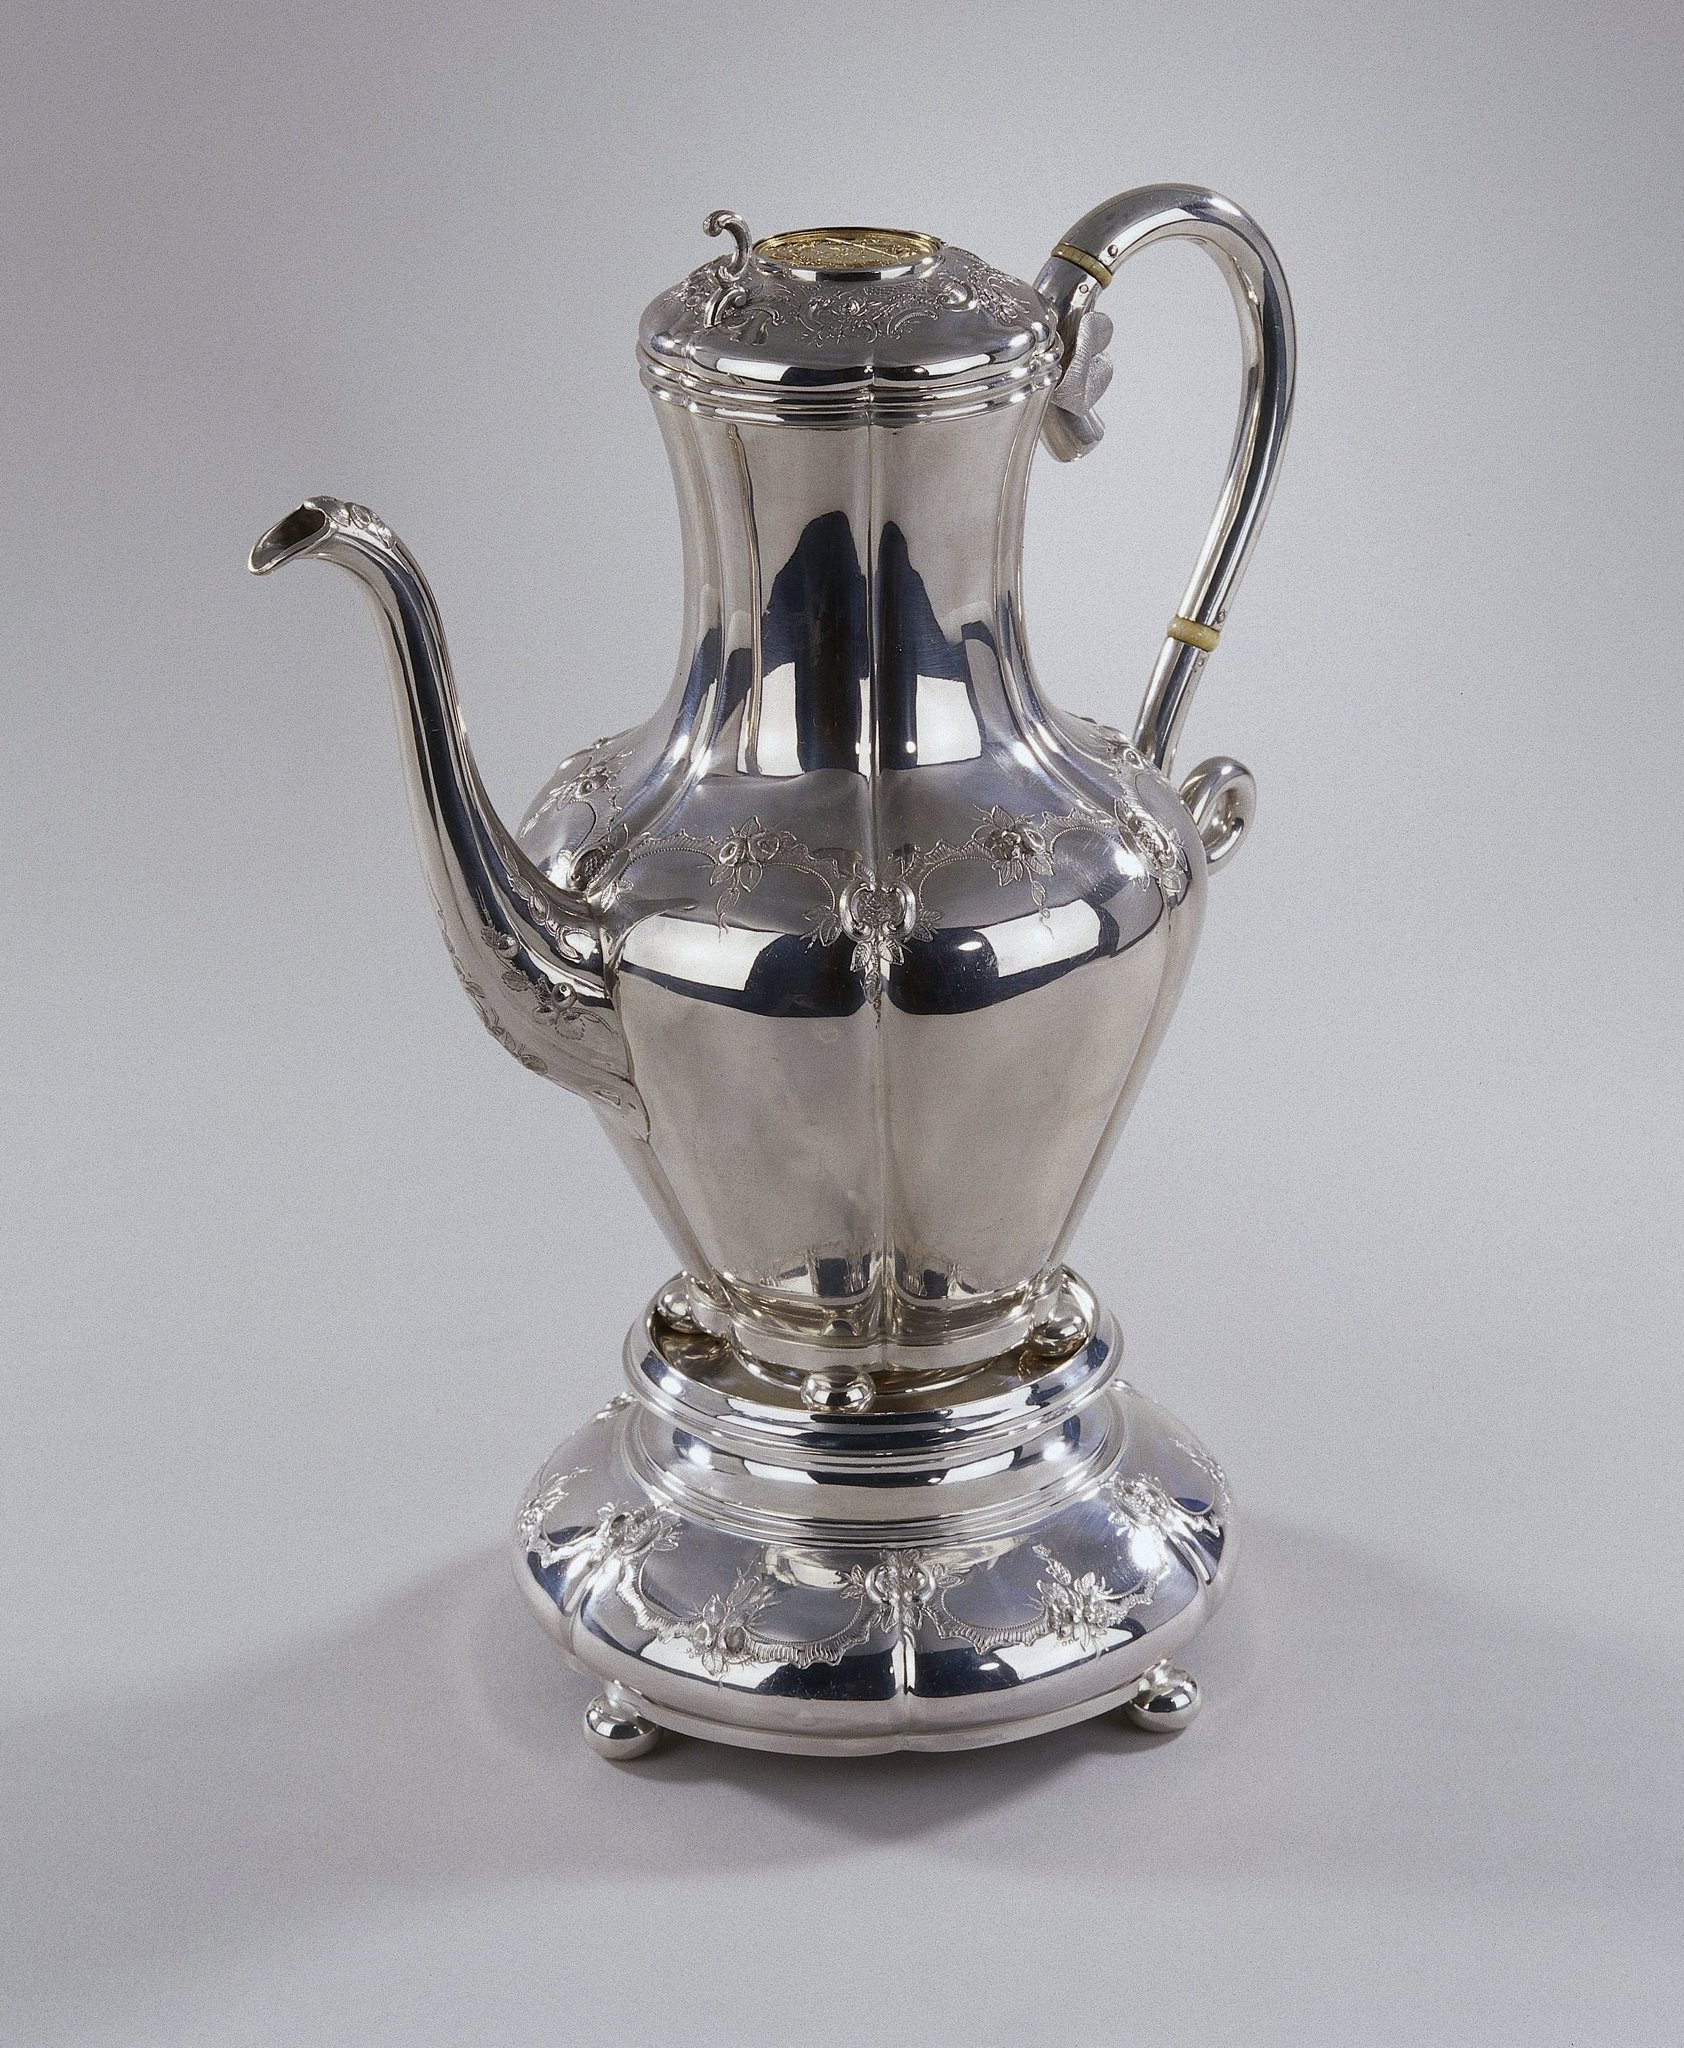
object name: coffee pot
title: Zilveren koffiepot uit een koffie- en theeservies van 11 delen dat toebehoorde aan J.D. Preuijt (1801-1887) aan hem gegeven bij zijn jubileum in 1873.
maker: pieter zöllner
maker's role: silversmith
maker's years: 1806-1894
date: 1872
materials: gold, ivory, silver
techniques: engraving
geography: rotterdam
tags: geervliet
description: Zilveren ronde koffiepot met geschulpte en gegraveerde ornamenten met bloemenmotieven. Een gouden penning is in het deksel gelegd en kan daaraan scharnieren. De penning is van de Hollandse maatschappij voor landbouw (1847): '1e prijs dragtige Vaarzen', 'J.D. Preuijt 's Gravenhage 1872'. Ivoren ringen in het hengsel. In de pot zit los een filter met handvat en daarin los een koffiestamper. Tussen handvat en deksel zijn twee bladeren bevestigd. De pot staat op vier pootjes.